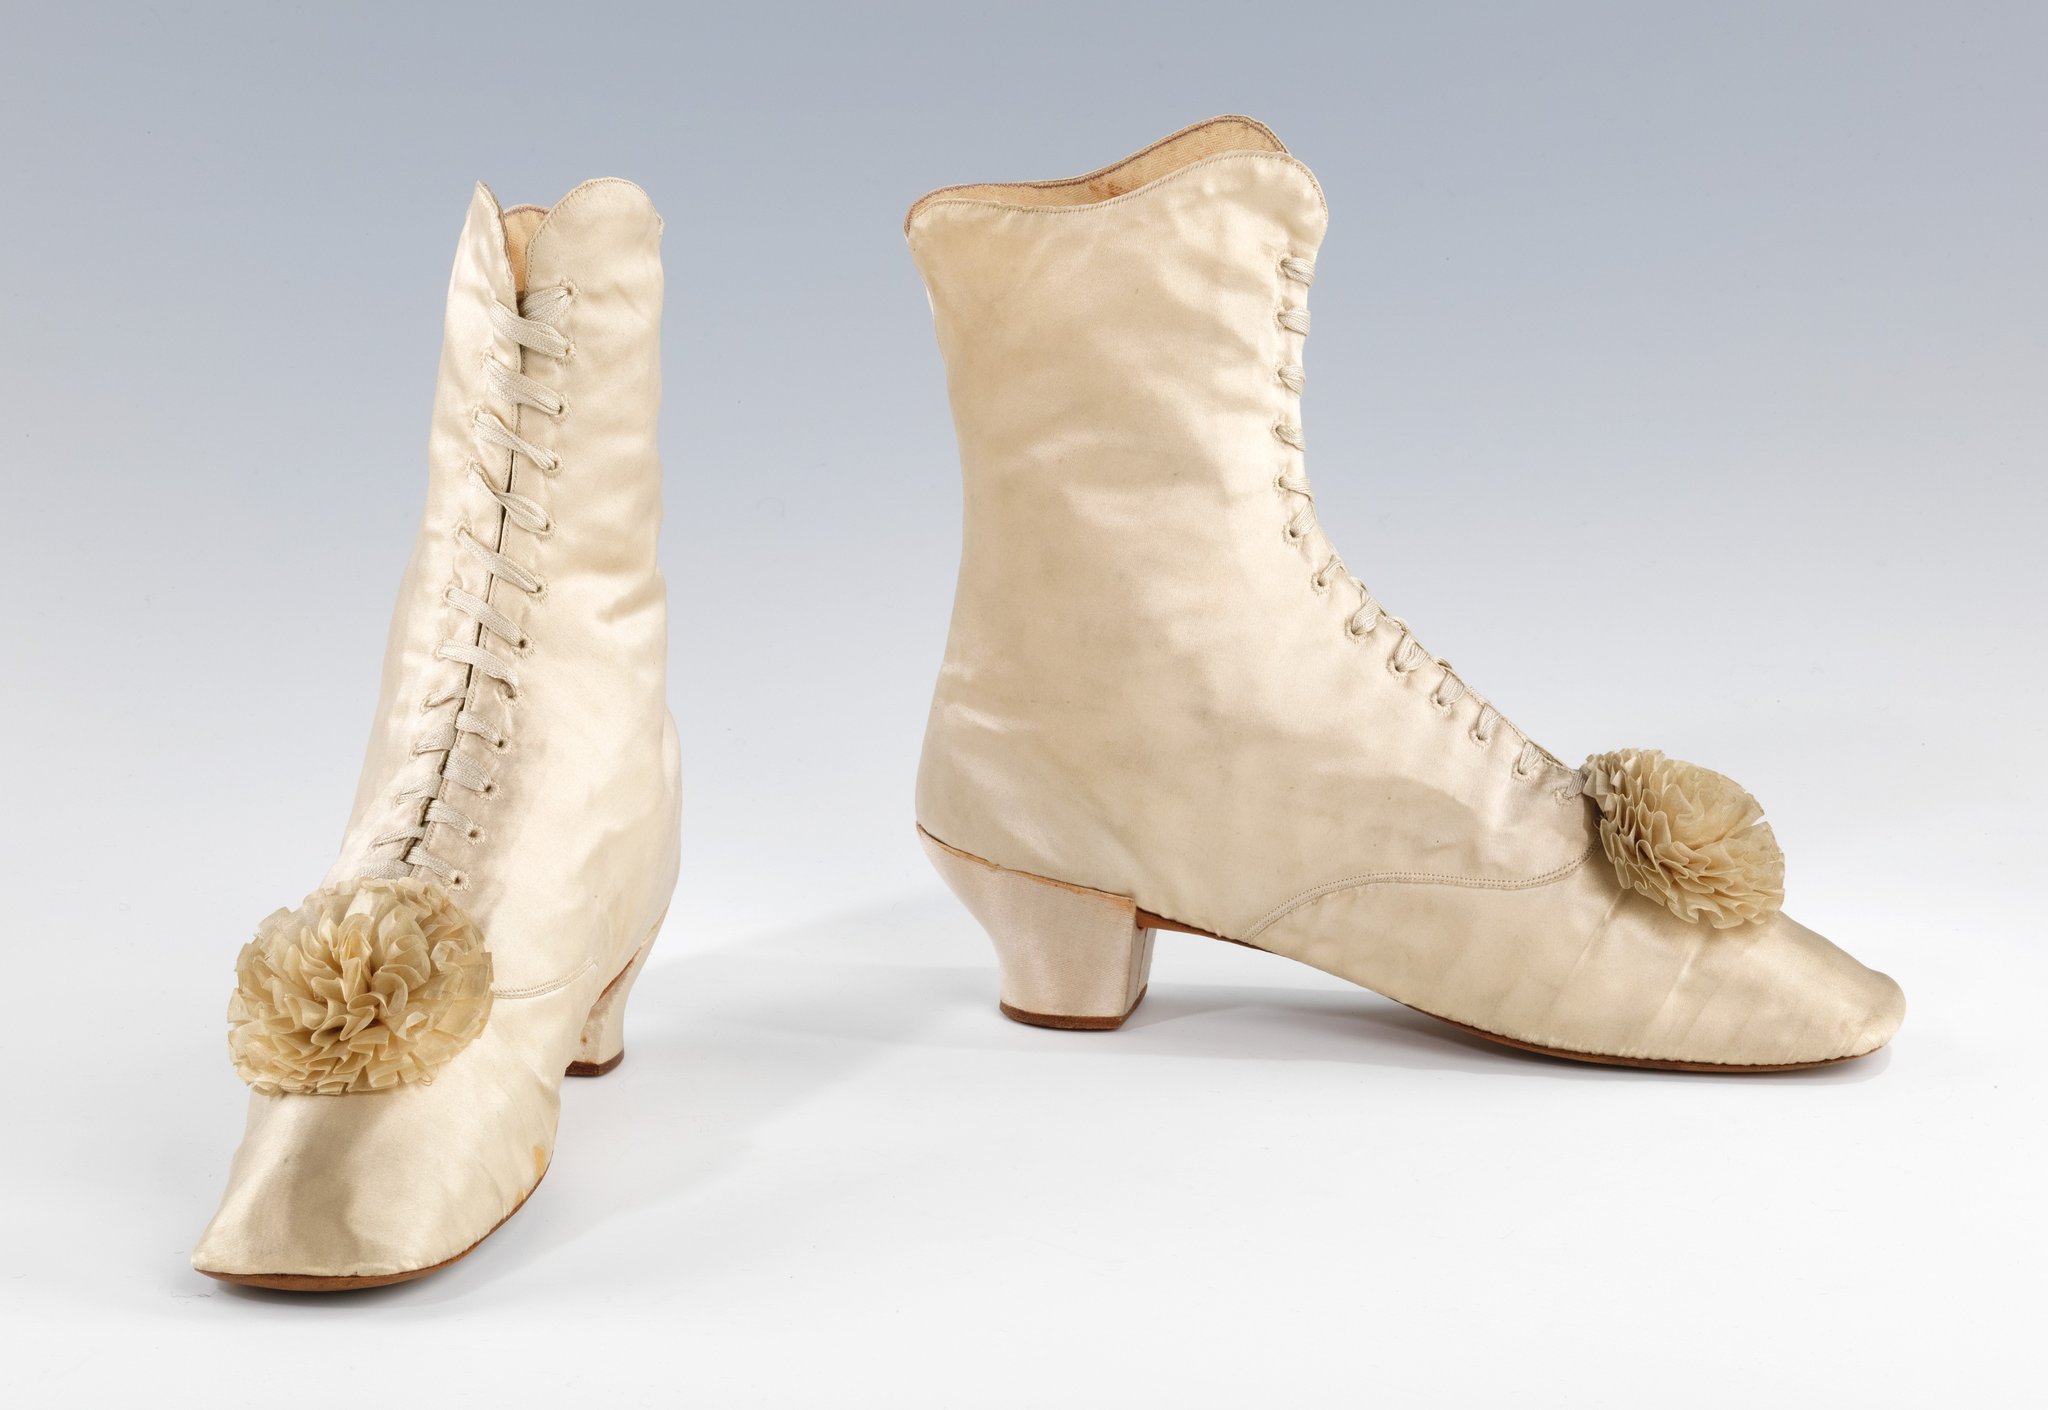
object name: evening boot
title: Evening boots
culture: french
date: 1860-1869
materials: silk